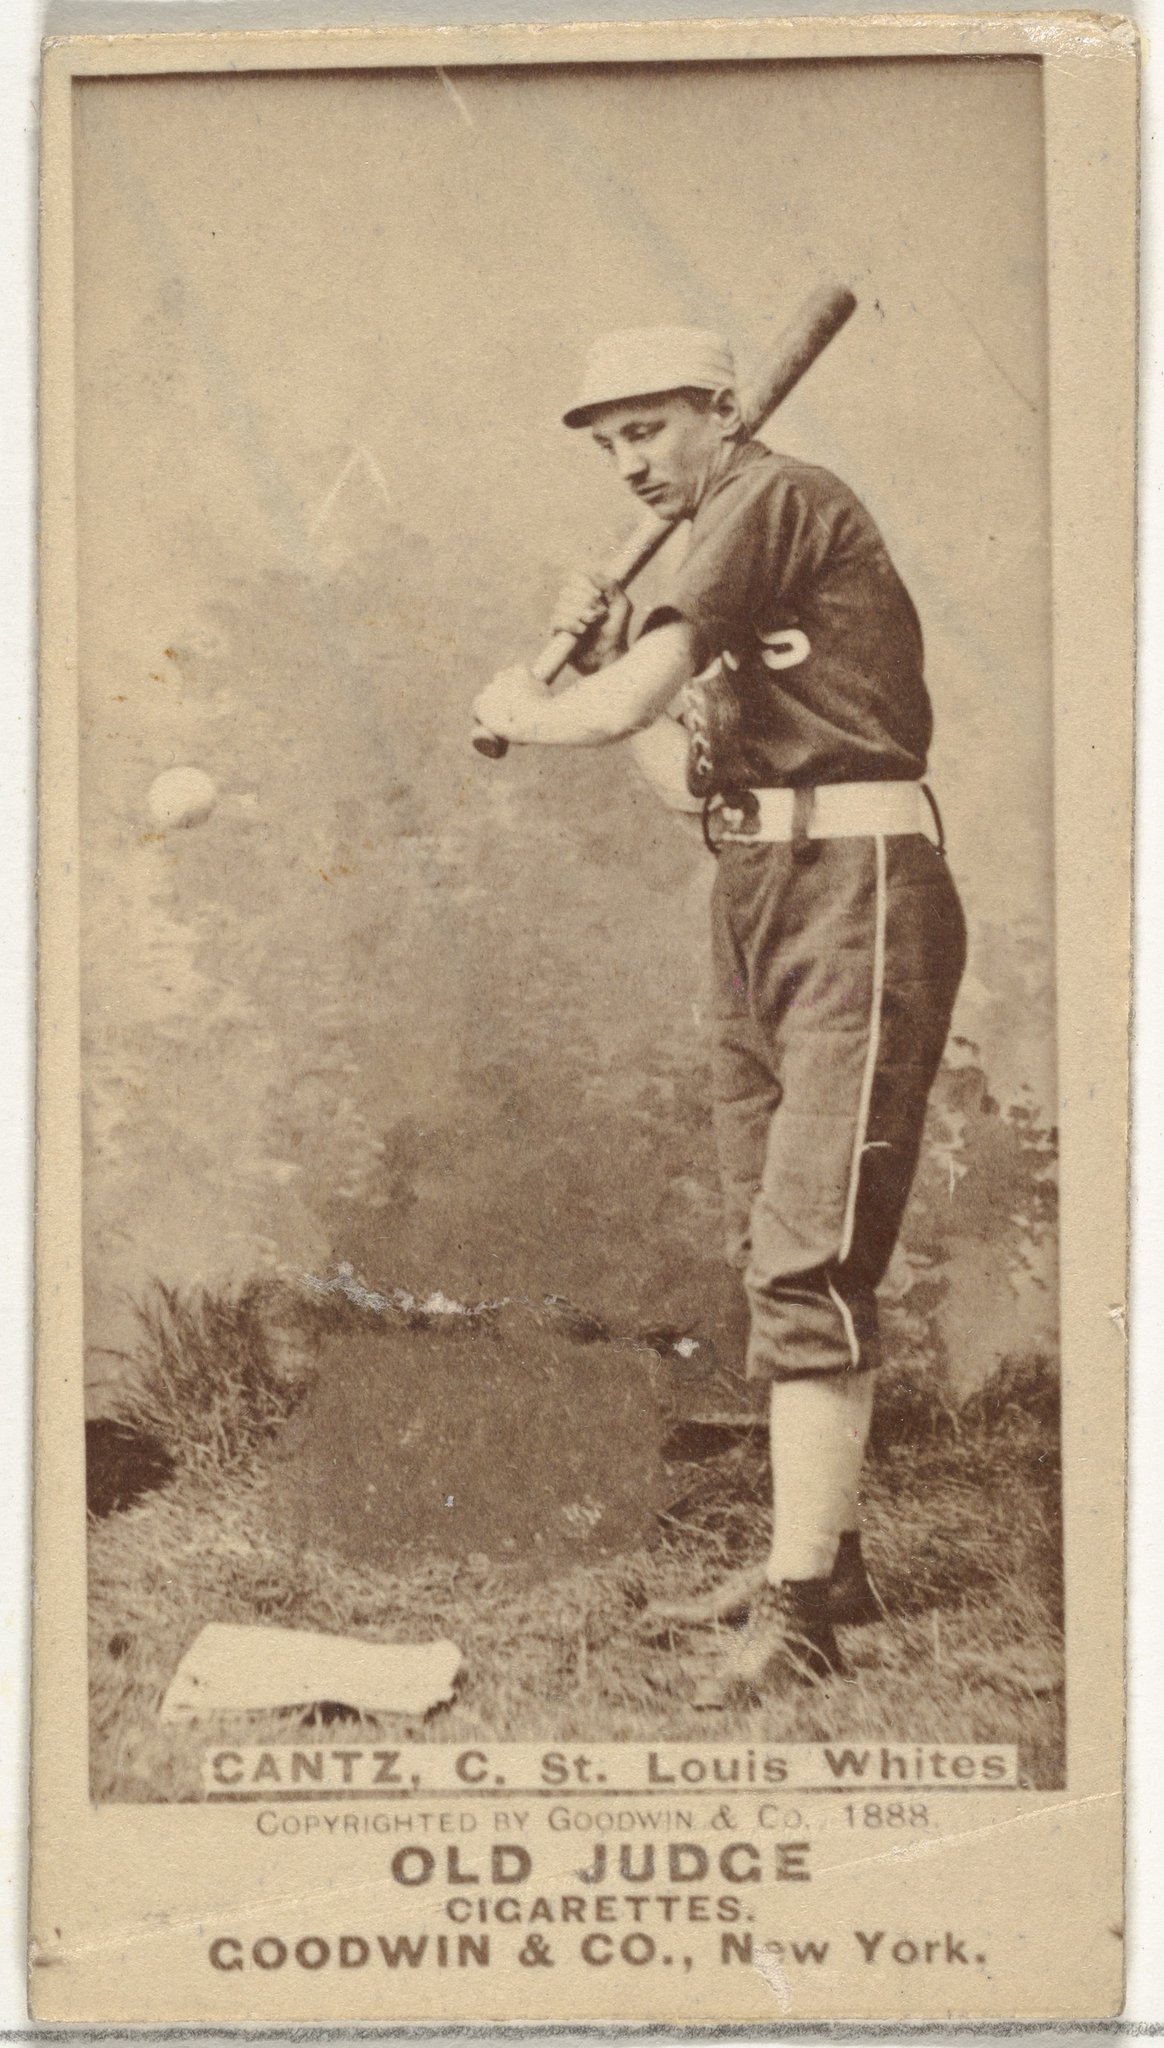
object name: baseball card, photograph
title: Bartholomew L. "Bart" Cantz, Catcher, St. Louis Whites, from the Old Judge series (N172) for Old Judge Cigarettes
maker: goodwin & company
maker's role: publisher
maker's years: 1850-1950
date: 1888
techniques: albumen silver print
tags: men,portraits,baseball,athletes